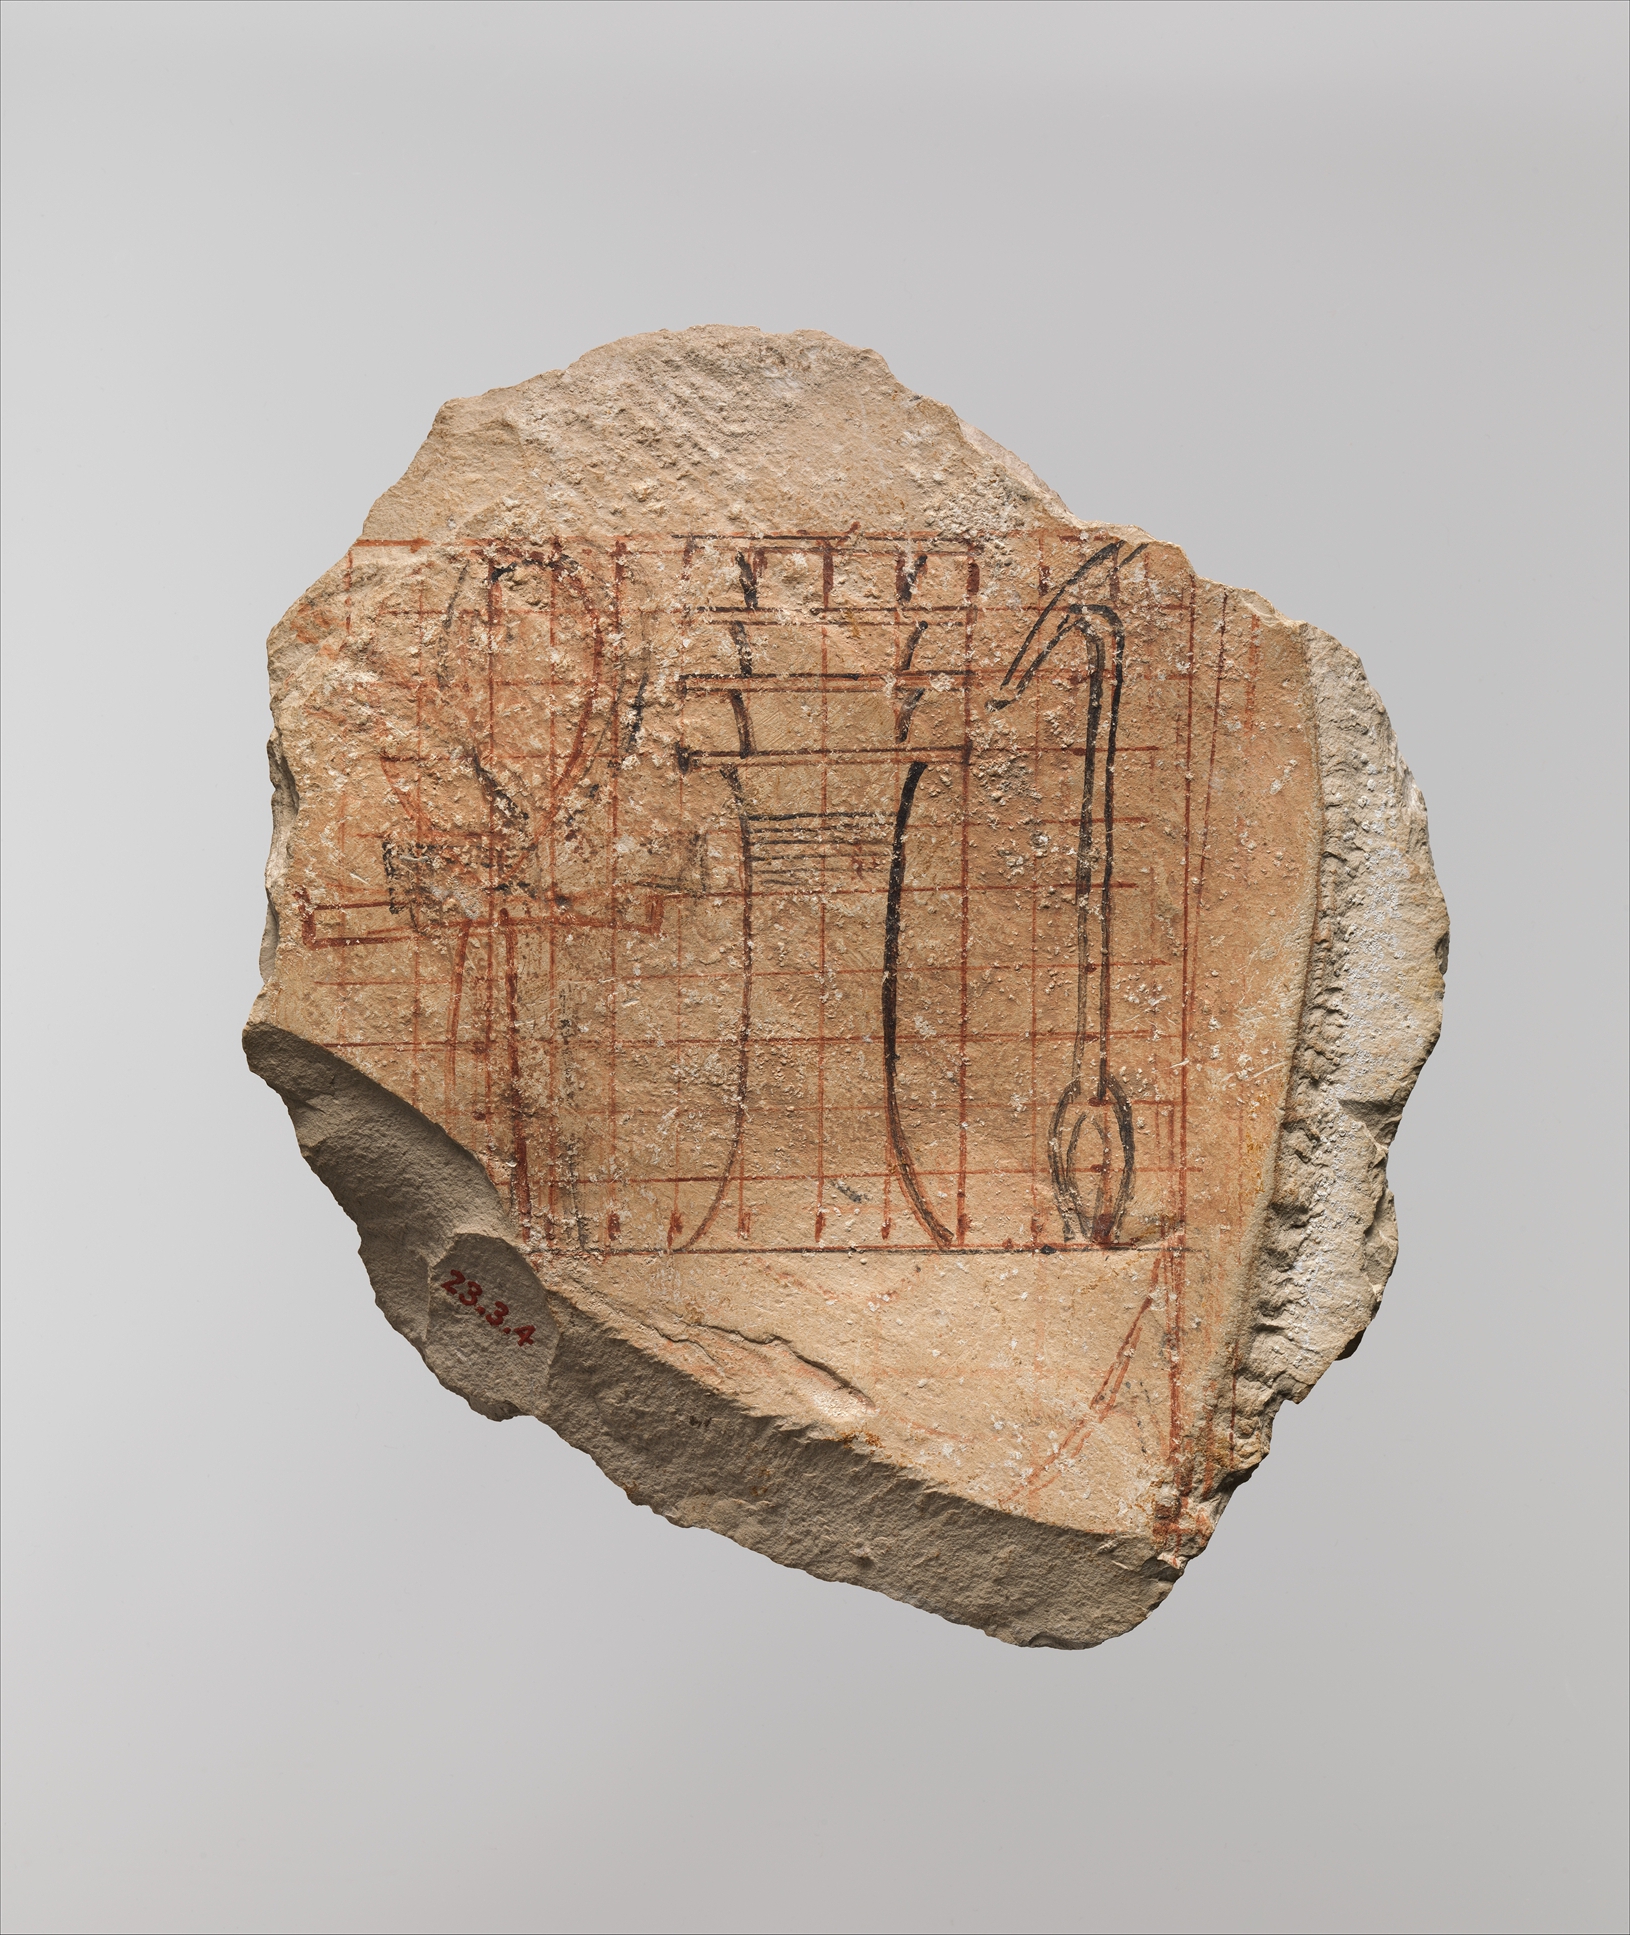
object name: ostracon, grid, hieroglyphic motto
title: Artist's Scaled Drawing of Hieroglyphs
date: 1479-1458 BCE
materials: ink, limestone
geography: egypt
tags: hieroglyphs